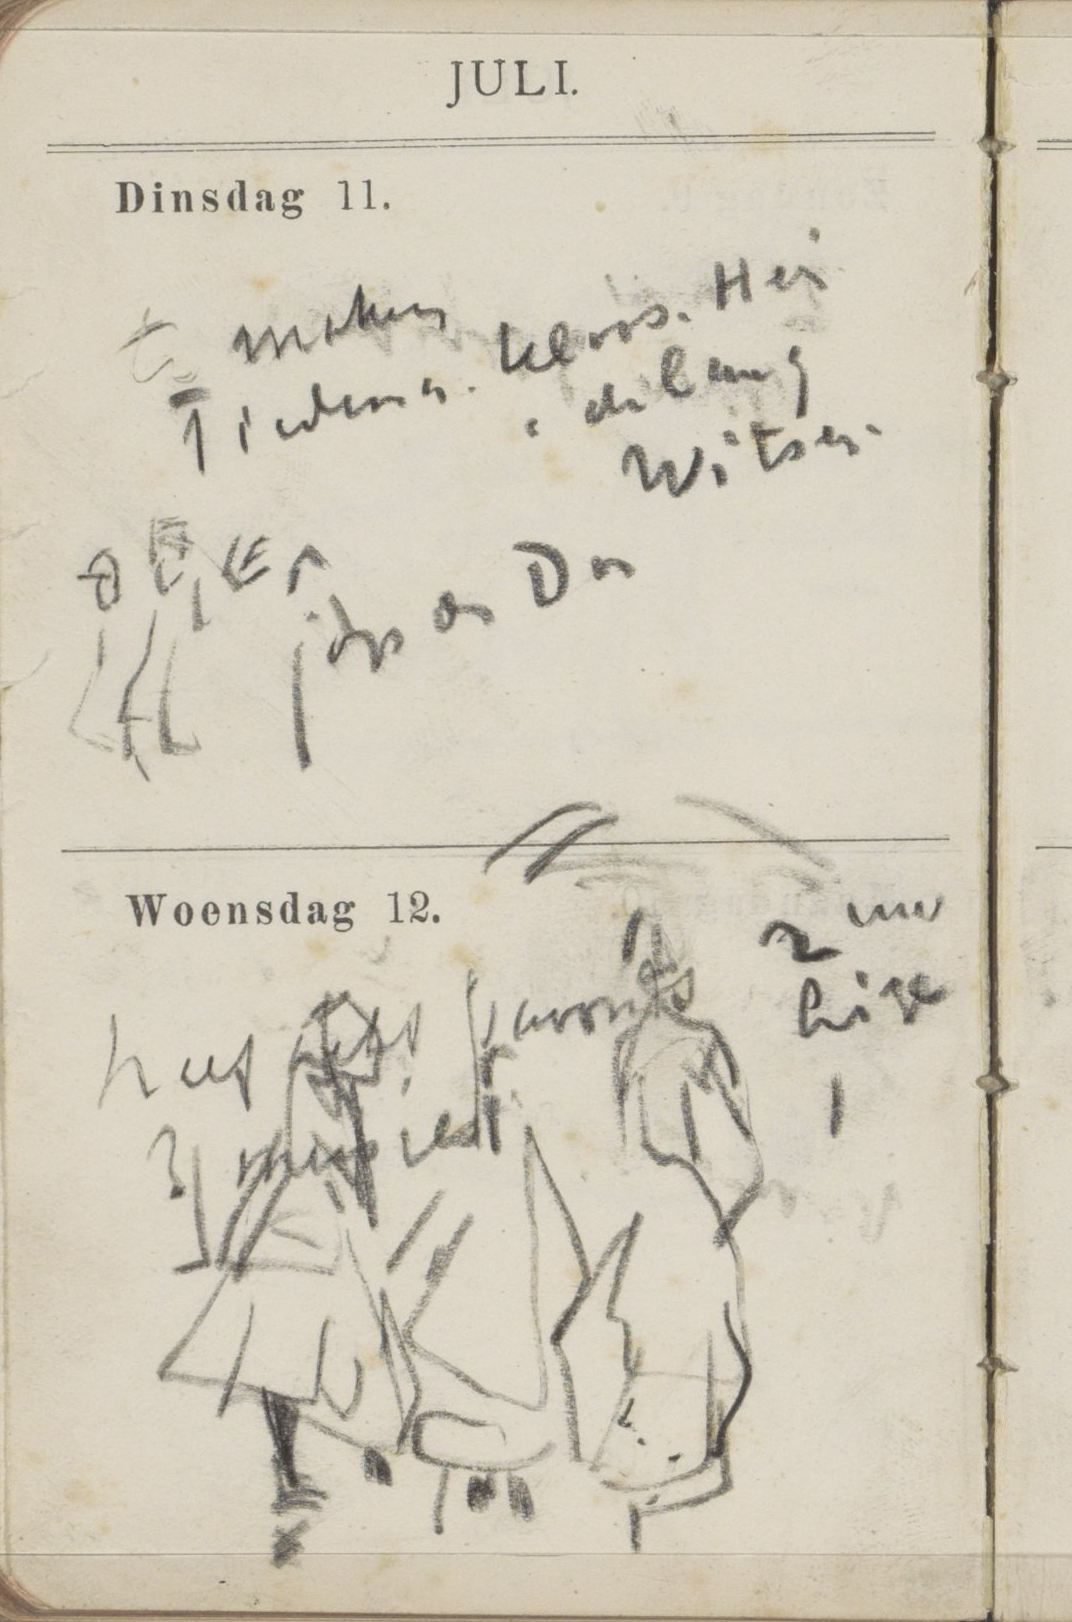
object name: sketchbook leaf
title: Vrouwen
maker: george hendrik breitner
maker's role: draughtsman, painter, print maker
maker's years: 1857-1923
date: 1893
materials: chalk, paper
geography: amsterdam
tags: adolescent, young woman, maiden, adult woman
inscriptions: annotation: ‘makers/ Tiedema.[?] Kloos. [...]/ de Lang/ Witsen/ [...]/ 2 uur/ Lize/ [...]’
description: Pagina 119 uit een als schetsboek gebruikte agenda met 108 bladen.